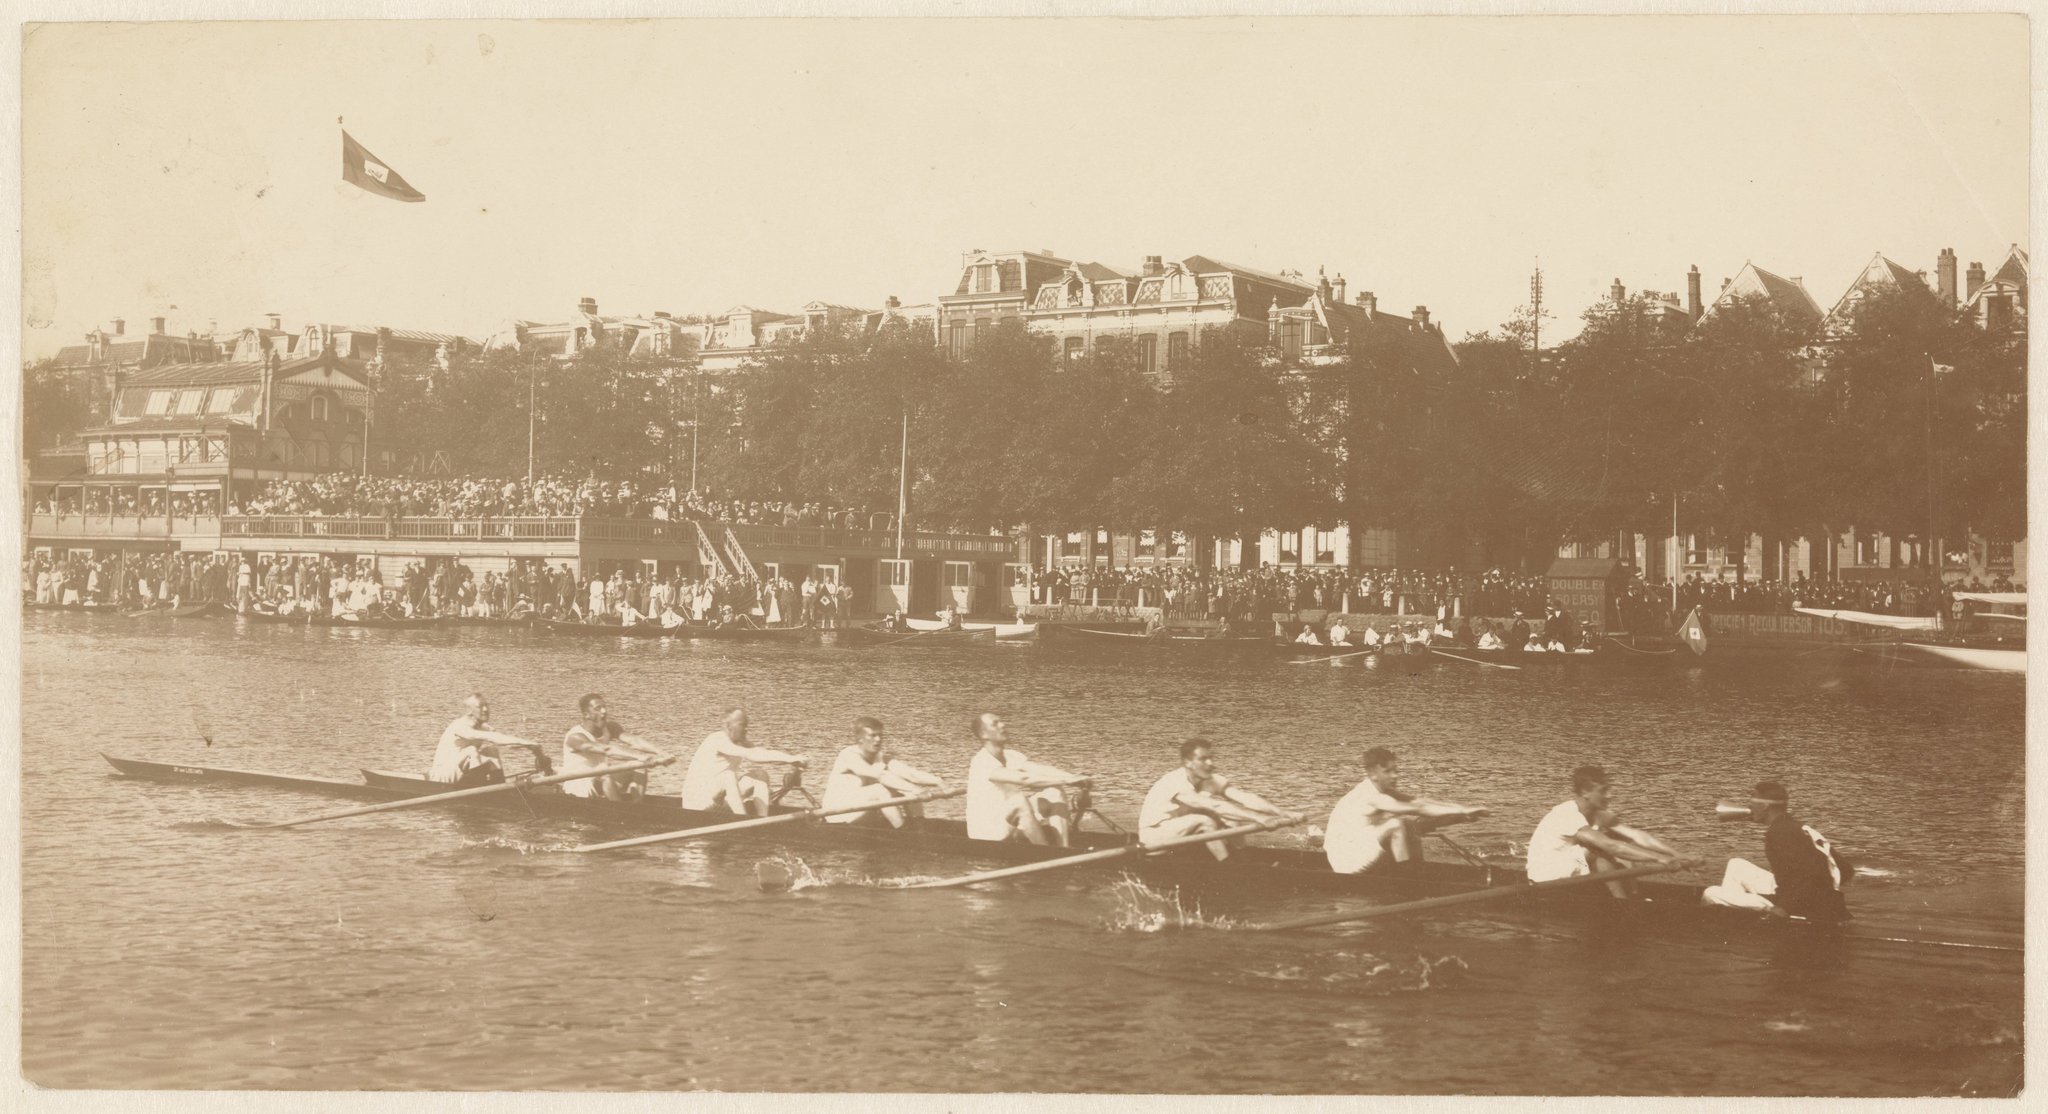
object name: photograph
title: Koninklijke roeiwedstrijd op de Amstel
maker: e. van elfrinkhoff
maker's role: fotograaf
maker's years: 1860-1921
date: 1918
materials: paper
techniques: gelatin silver print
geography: amsterdam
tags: rowing-boat, canoe, etc., canals, waters (in city)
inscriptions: stamp: ‘E. van Elfrinkhoff Amsterdam, fotograaf de Ruijterstraat 10-12, tel. 10540’, annotation: ‘1918, jonge 8 de Maas’